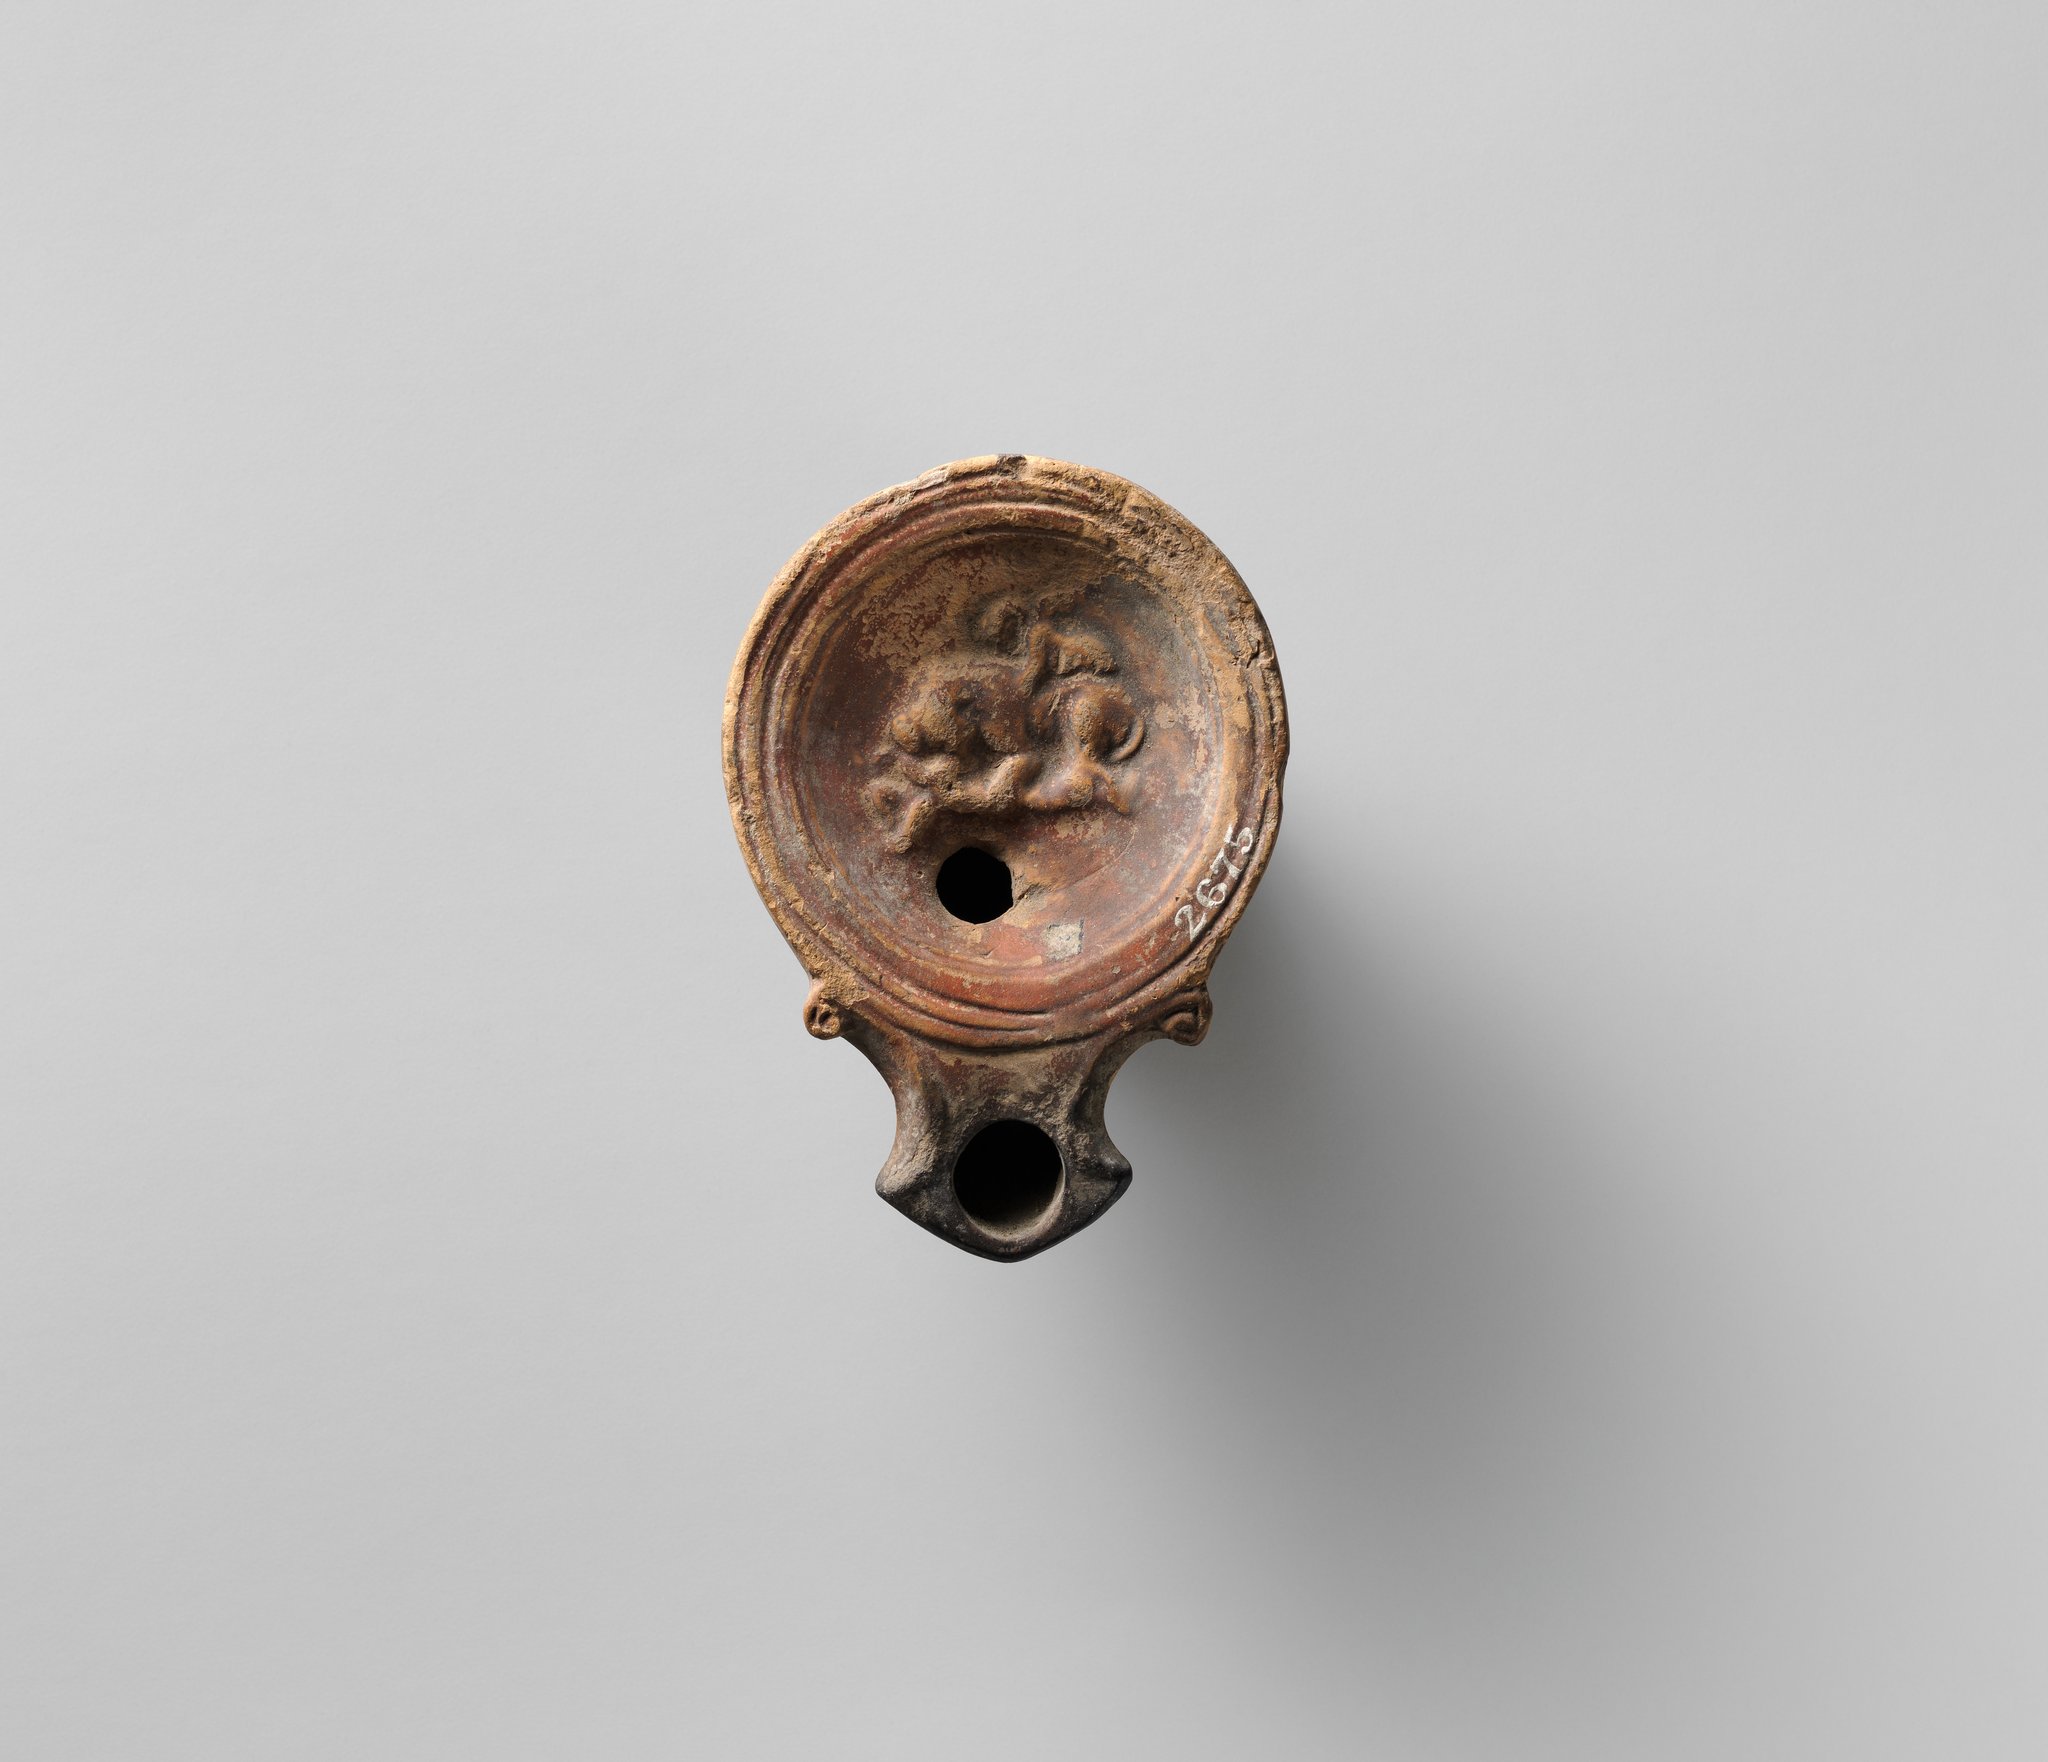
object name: lamp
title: Terracotta oil lamp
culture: roman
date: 100 BCE-100 CE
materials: terracotta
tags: eros